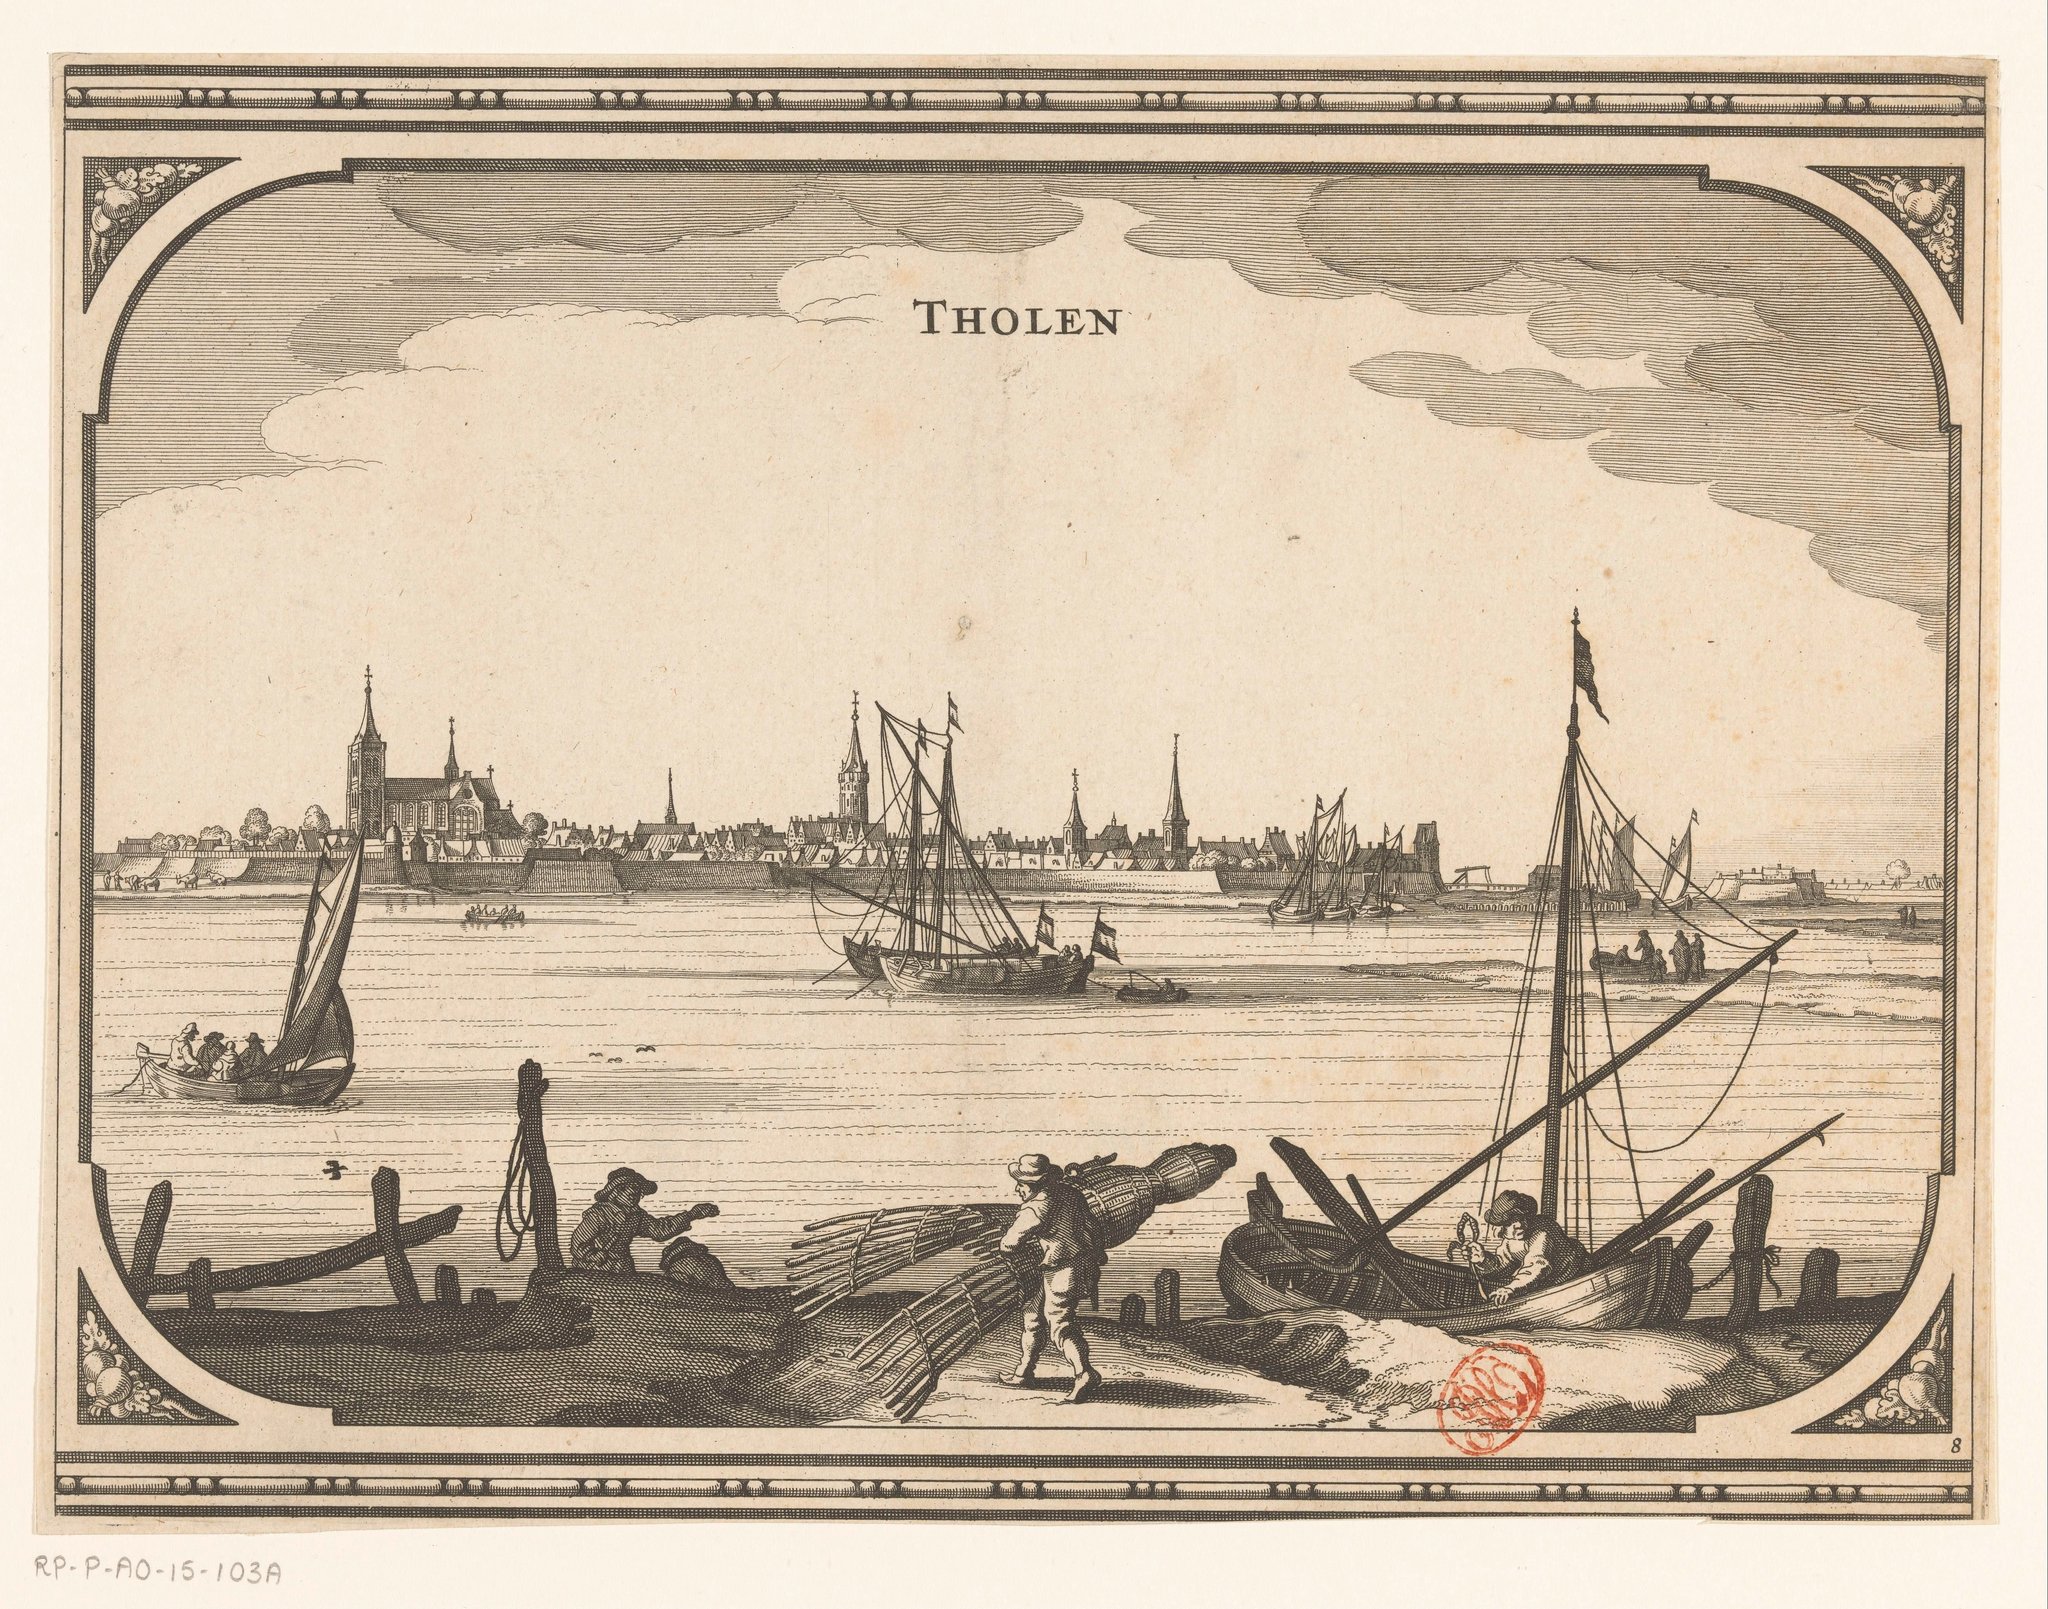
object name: print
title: Gezicht op Tholen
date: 1657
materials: paper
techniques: etching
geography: amsterdam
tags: sailing-ship, sailing-boat, church (exterior), rowing-boat, canoe, etc., prospect of city, town panorama, silhouette of city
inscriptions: collector's mark: Lugt 195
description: Huidige staat van prent ook gebruikt in: Theatrum praecipuarum urbium ducatus Brabantiae nec non comitatuum Flandriae et Zelandiae. Amsterdam: Nicolaes Visscher (I), 1657. Verwarring rondom de datering kan ontstaan door het feit de prenten die voorkomen in de bovengenoemde publicaties ook voorkomen in een eerder uitgegeven publicatie, waar ze later in zijn ingebonden (Boxhorn, Marcus Zuerius van. Chroniick van Zeelandt (…). 2 delen. Middelburg: Zacharias Roman, 1644).